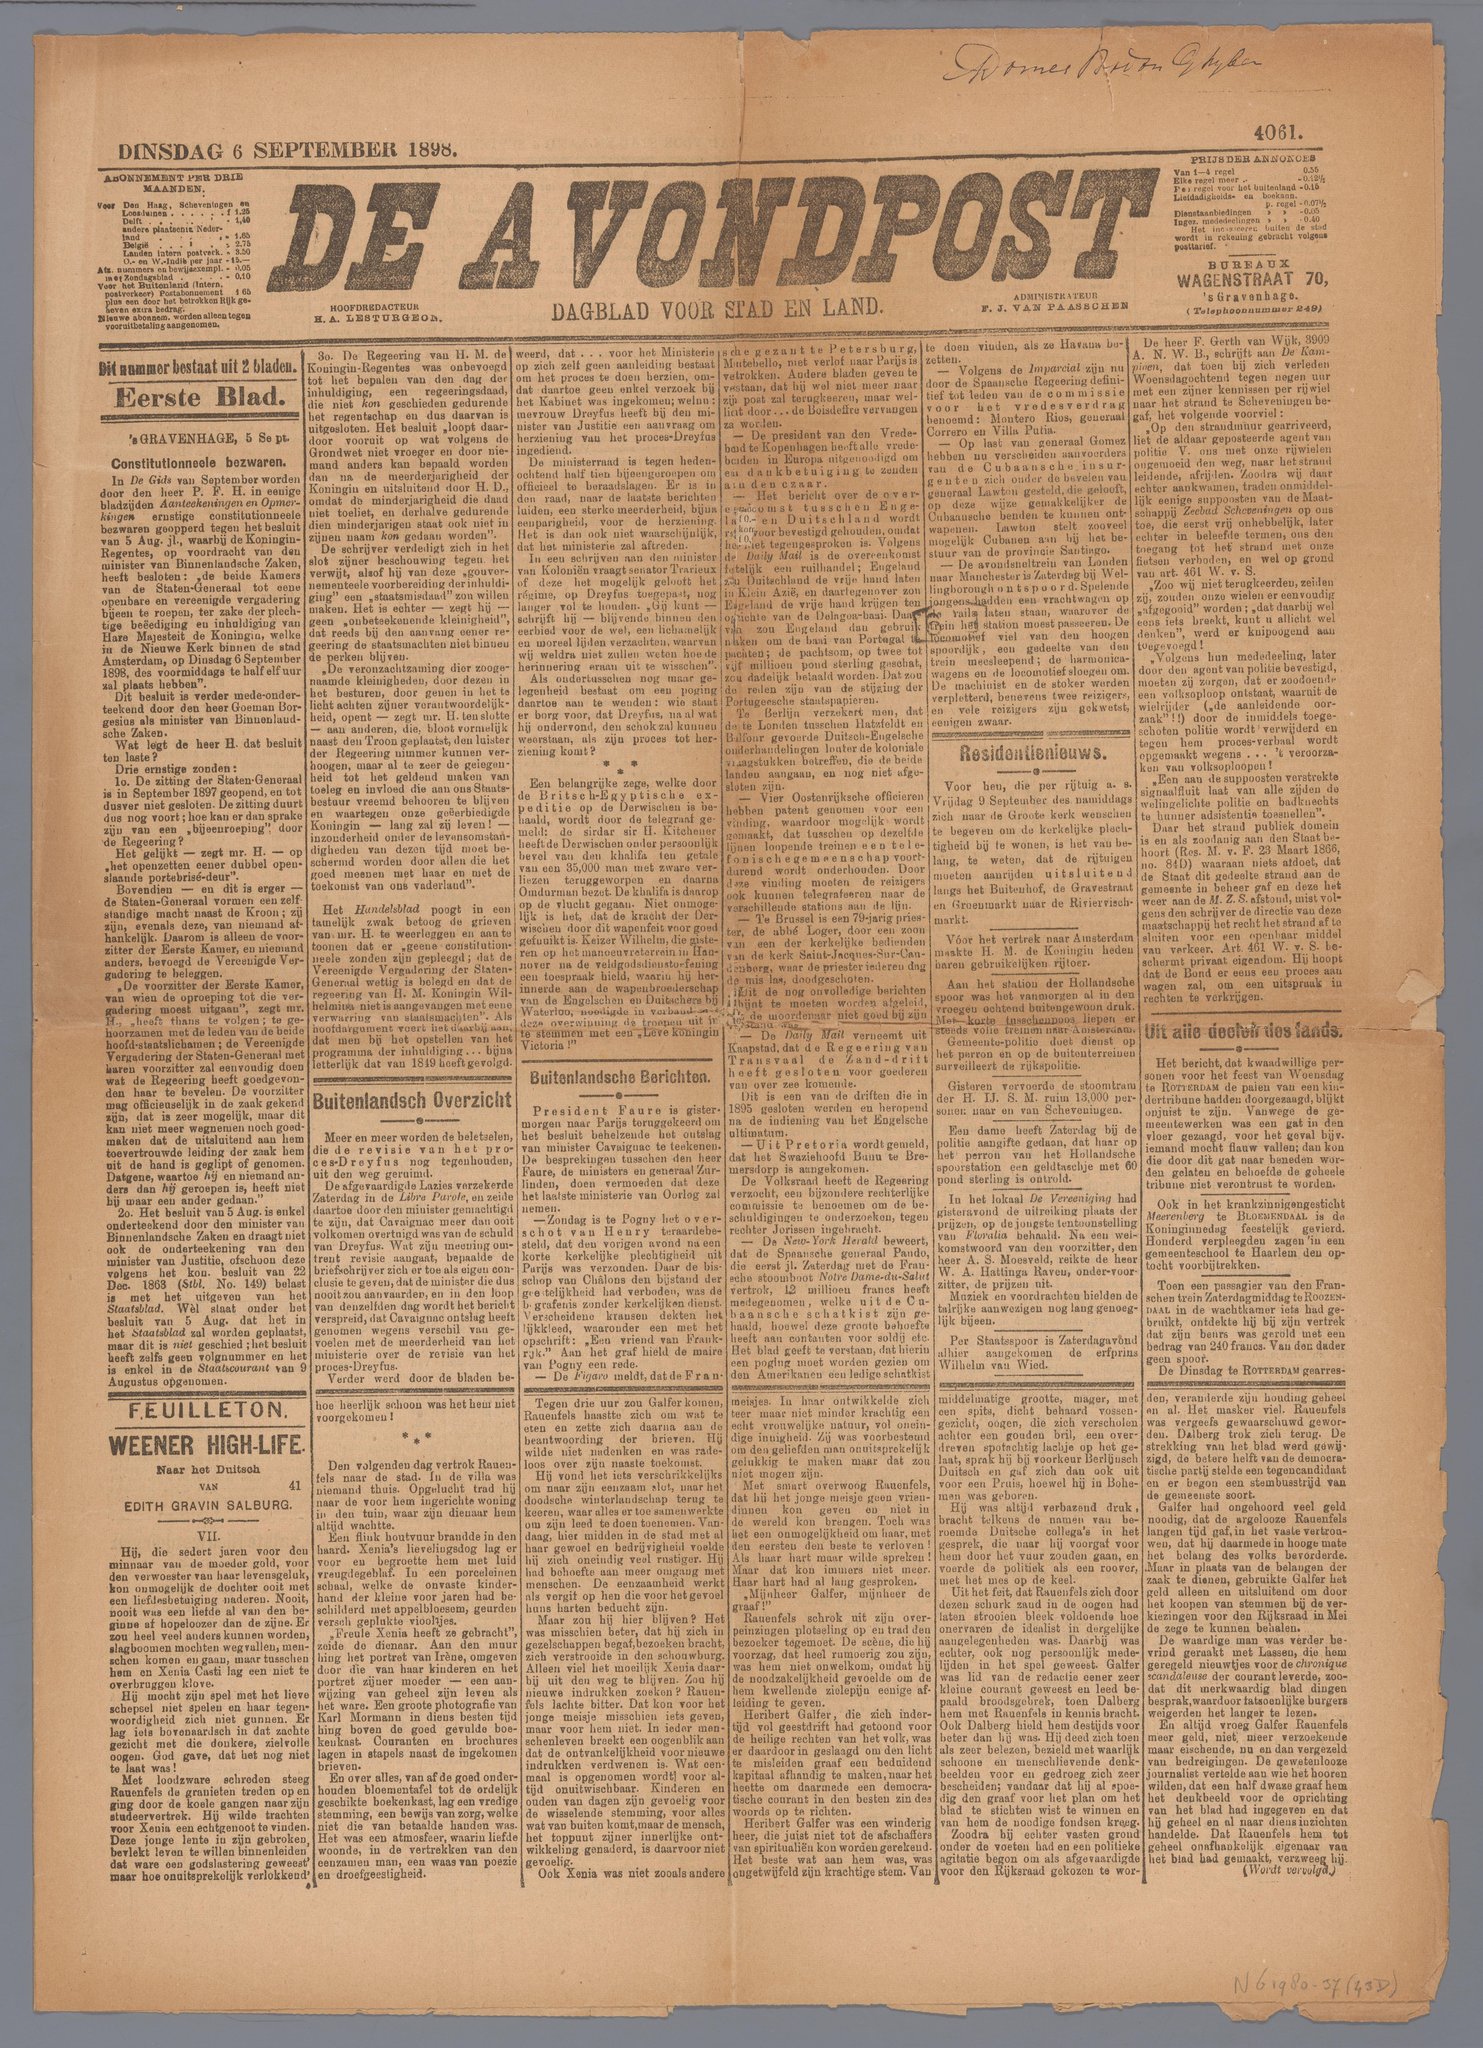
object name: newspaper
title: de Avondpost; dagblad voor stad en land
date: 1898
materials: paper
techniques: printing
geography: the hague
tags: the hague, print maker, wilhelmina of the netherlands, netherlands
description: Eén van een serie kranten, nrs. 4056 t/m 4073, van "de Avondpost" met berichten over de inhuldiging van koningin Wilhelmina 1898.